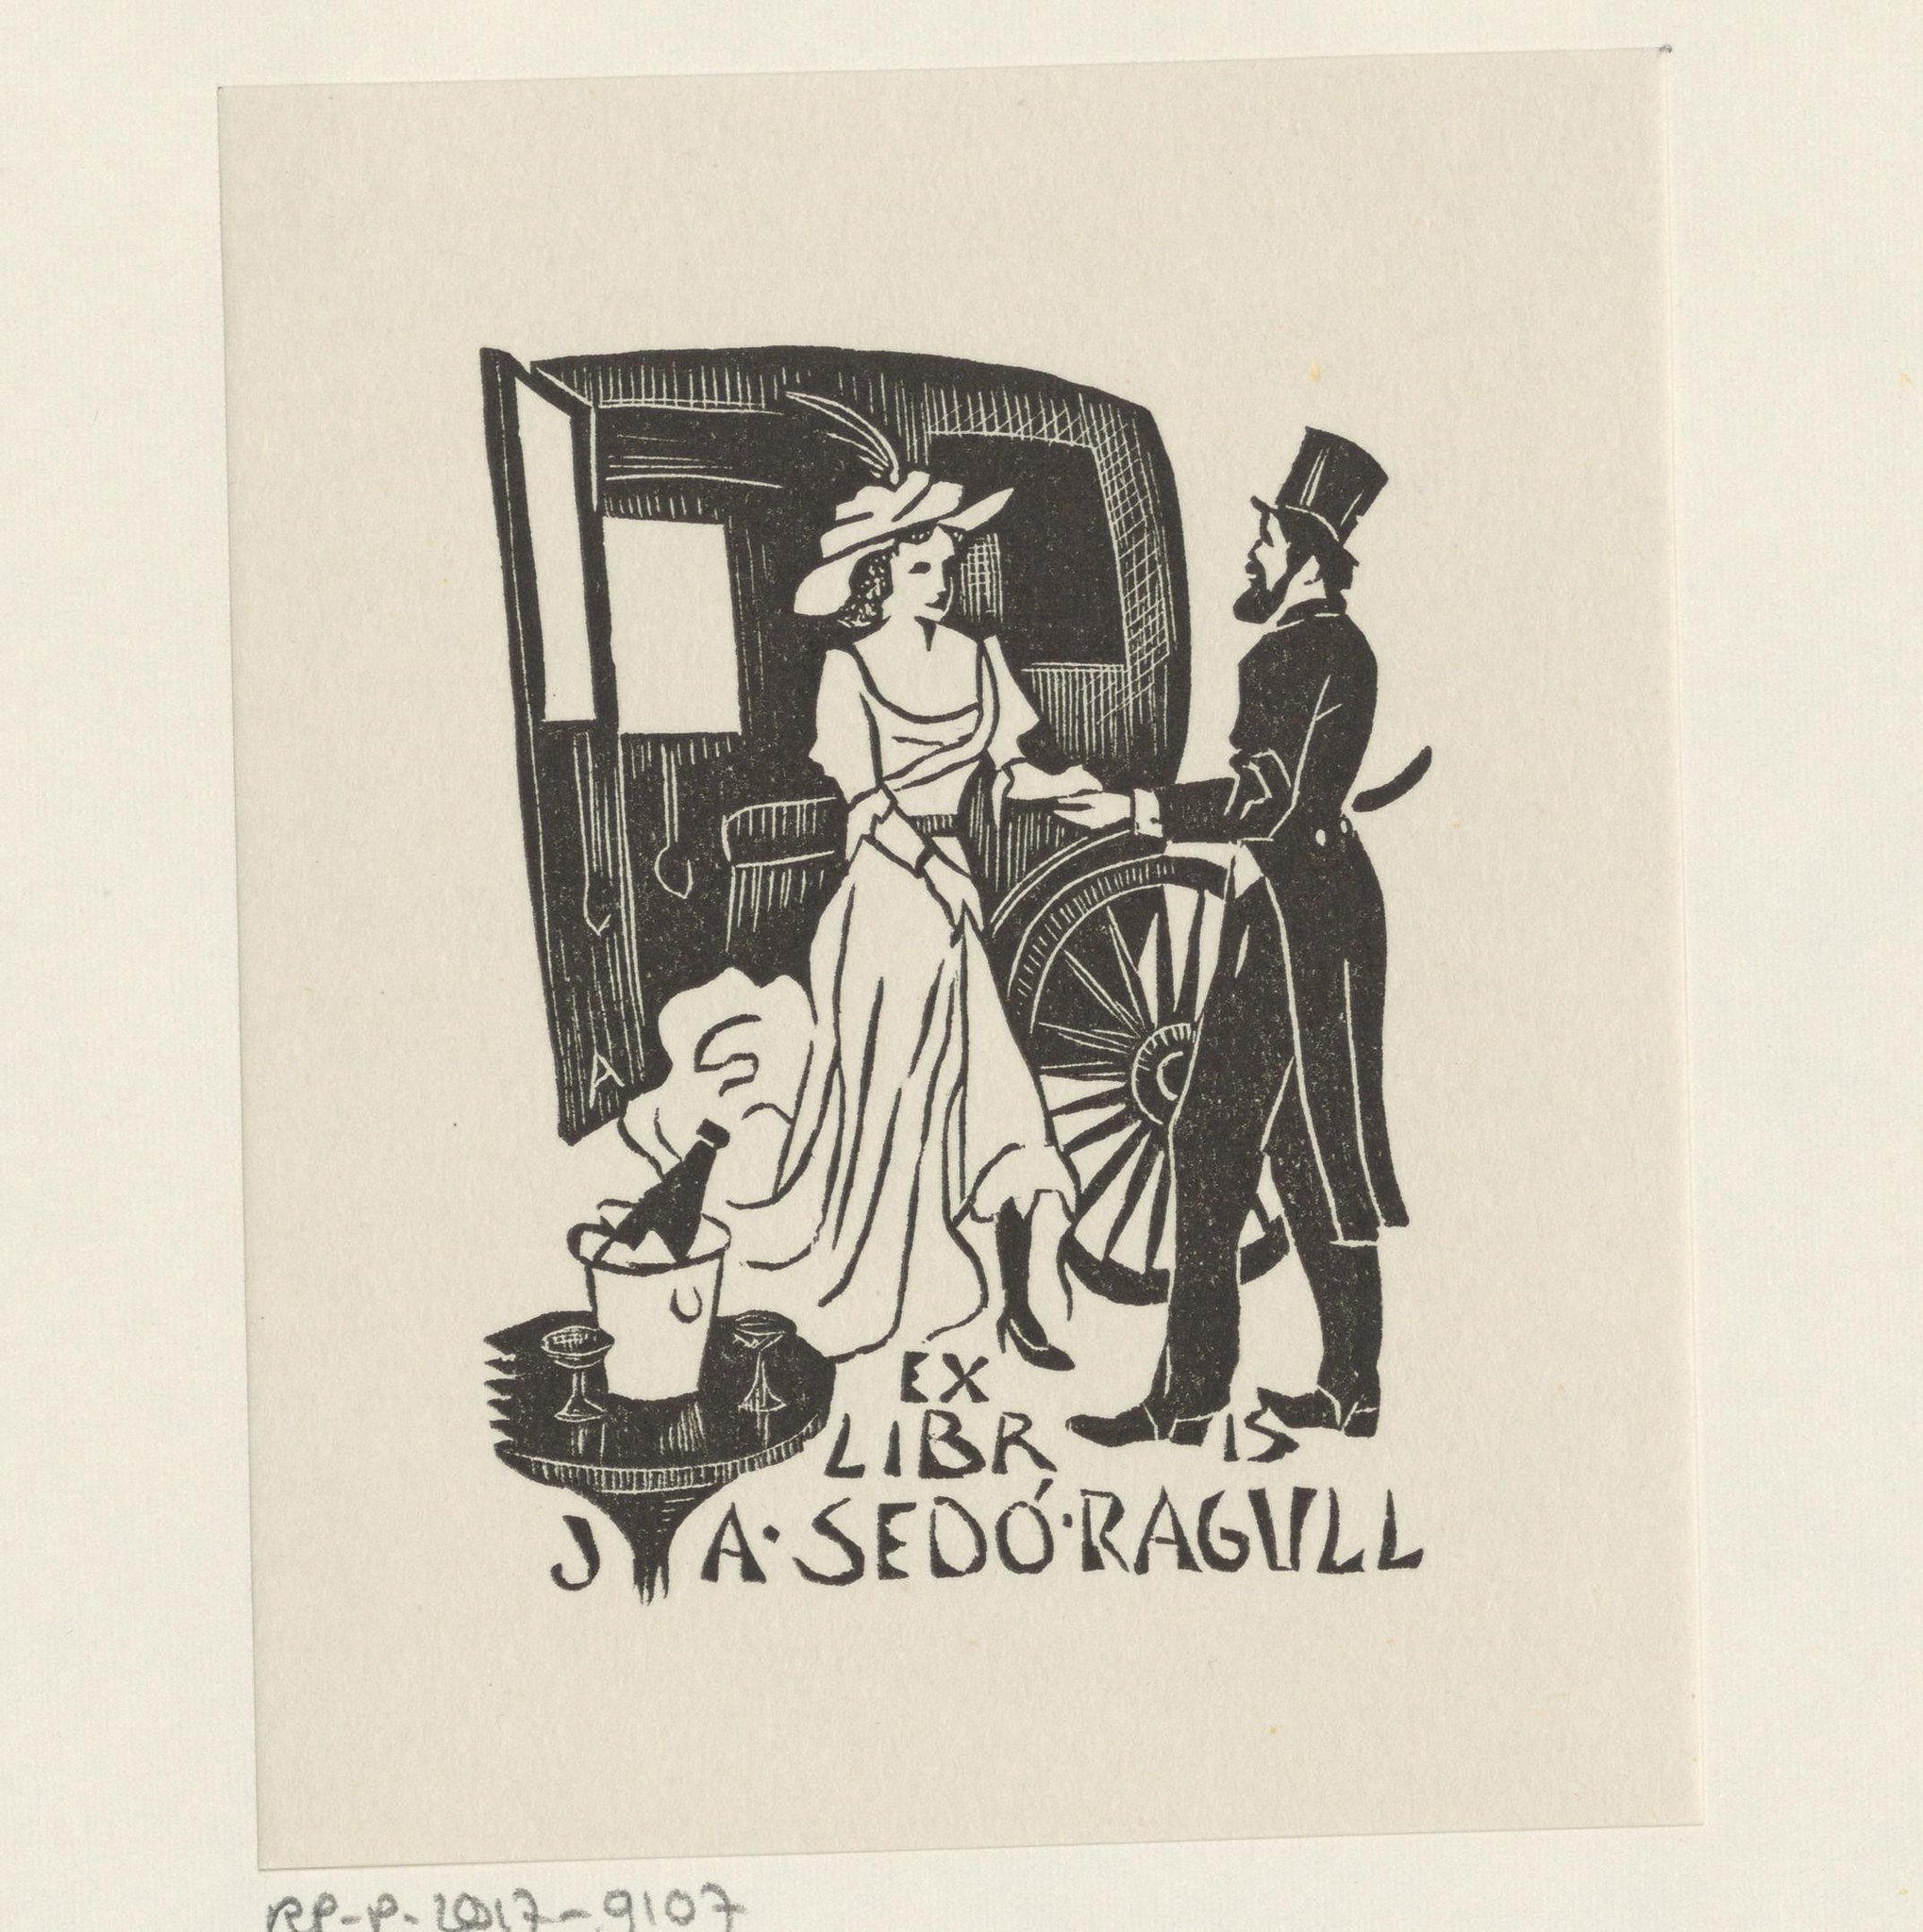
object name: bookplate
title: Ex libris J.A. Sedó Ragull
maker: françois d aquin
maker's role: print maker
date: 1959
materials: paper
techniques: woodcut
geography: france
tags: kinds of wine (with name), four-wheeled, animal-drawn vehicle, e.g.: cab, carriage, coach, head-gear: top hat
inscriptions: workshop stamp: ‘François d'Aquin/ xilografia/ Francia 1959’